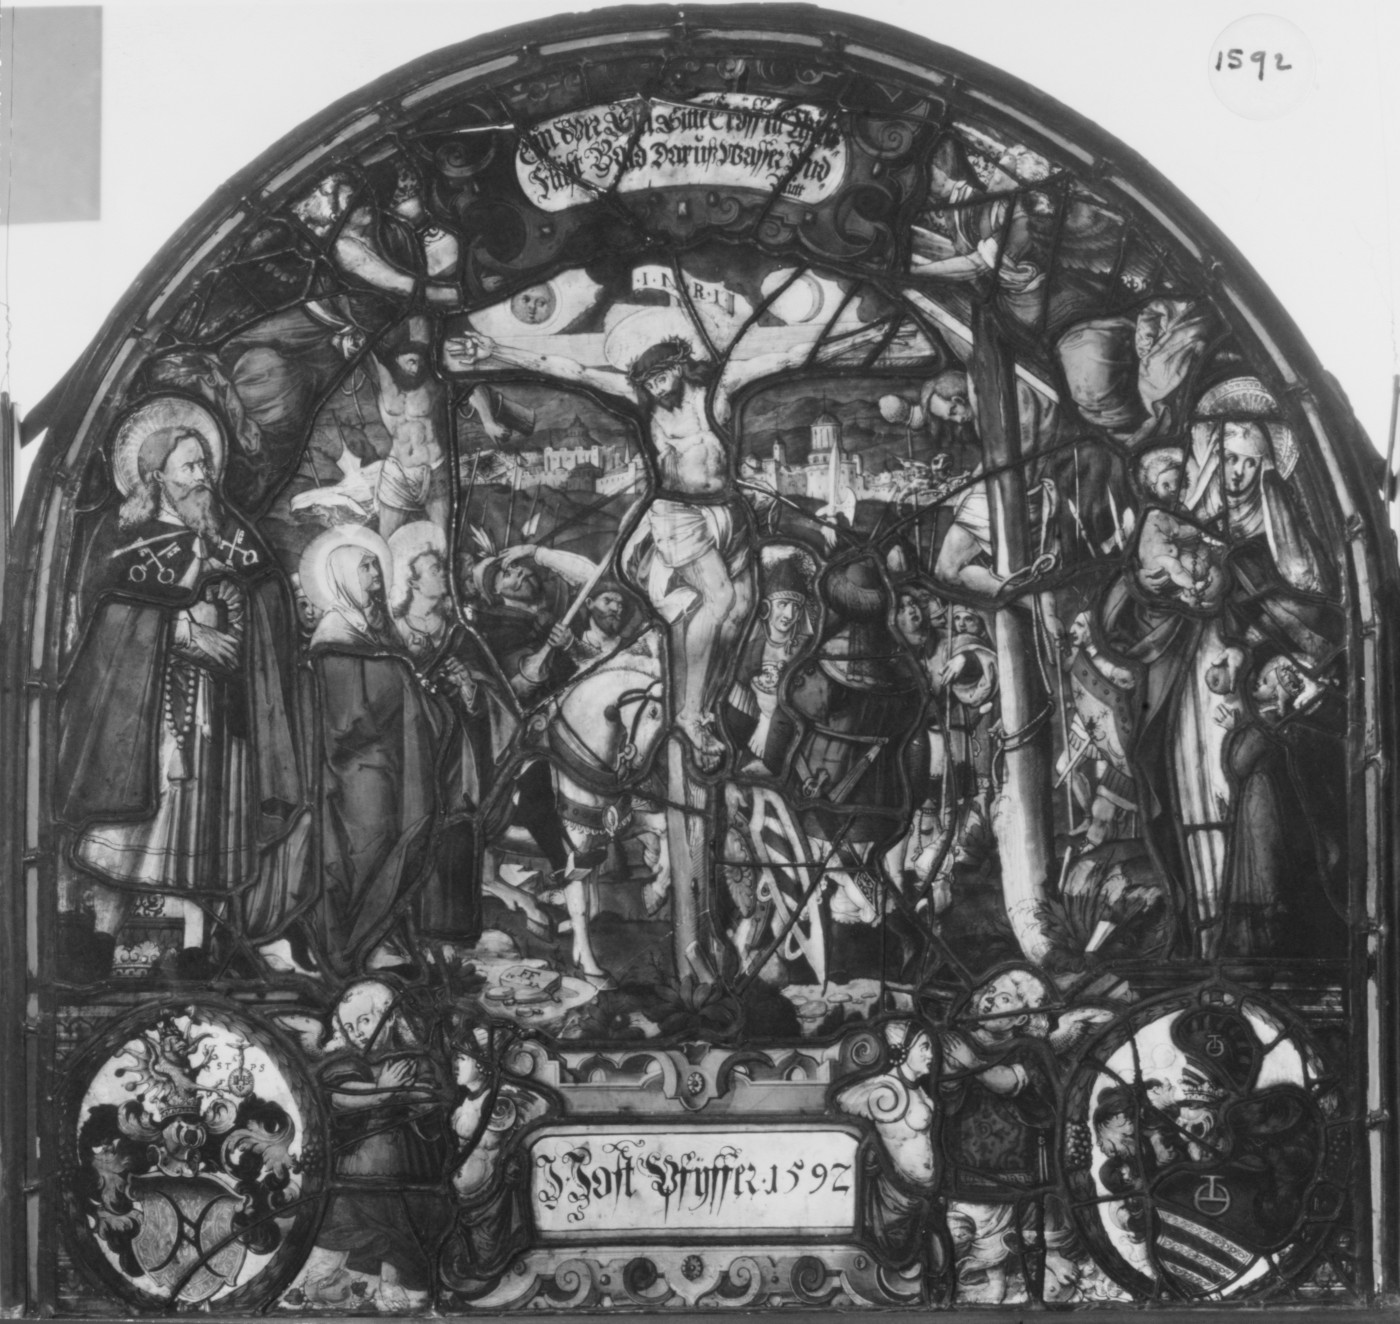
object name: panel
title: The Crucifixion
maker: franz fallenter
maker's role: artist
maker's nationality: german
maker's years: 1550-1616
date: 1592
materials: glass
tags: crucifixion